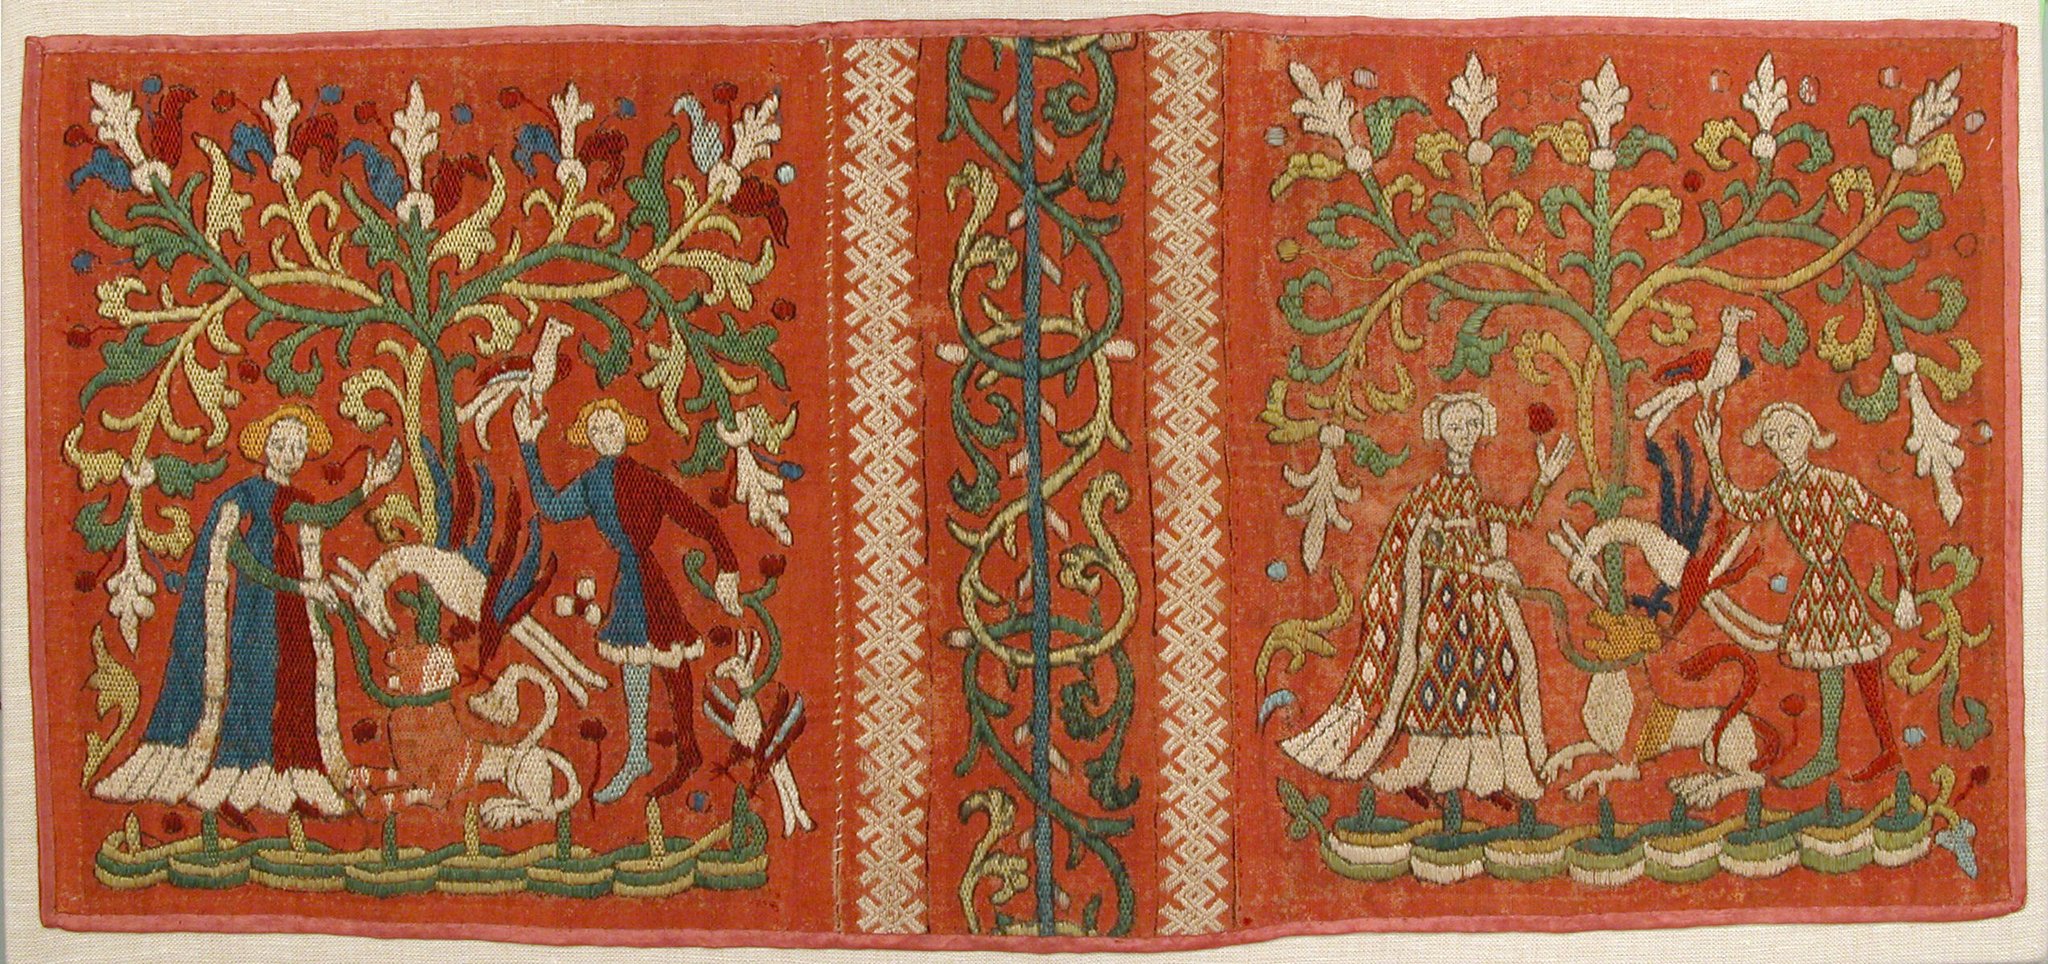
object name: embroidery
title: Embroideries with Allegorical Scenes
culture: german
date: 1450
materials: linen, pigment, silk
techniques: weave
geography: germany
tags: birds,men,women,dogs,allegory